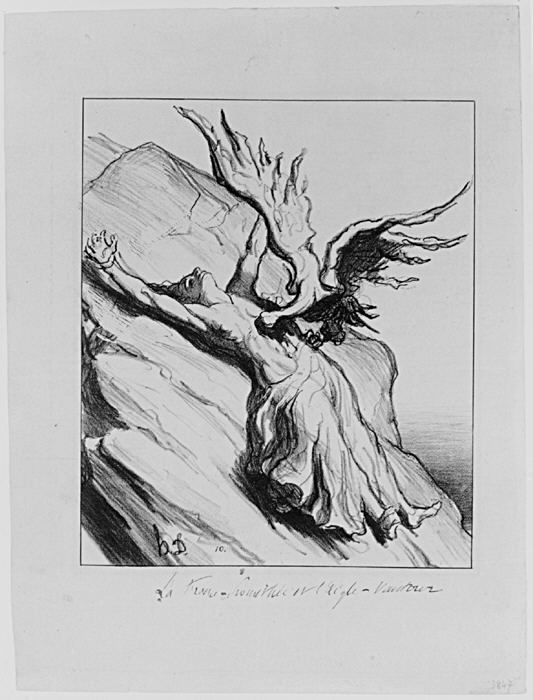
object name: print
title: France, Prometheus and the Vulture, from "News of the day"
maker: honoré daumier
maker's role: artist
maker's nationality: french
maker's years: 1808-1879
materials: paper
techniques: lithograph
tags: birds,men